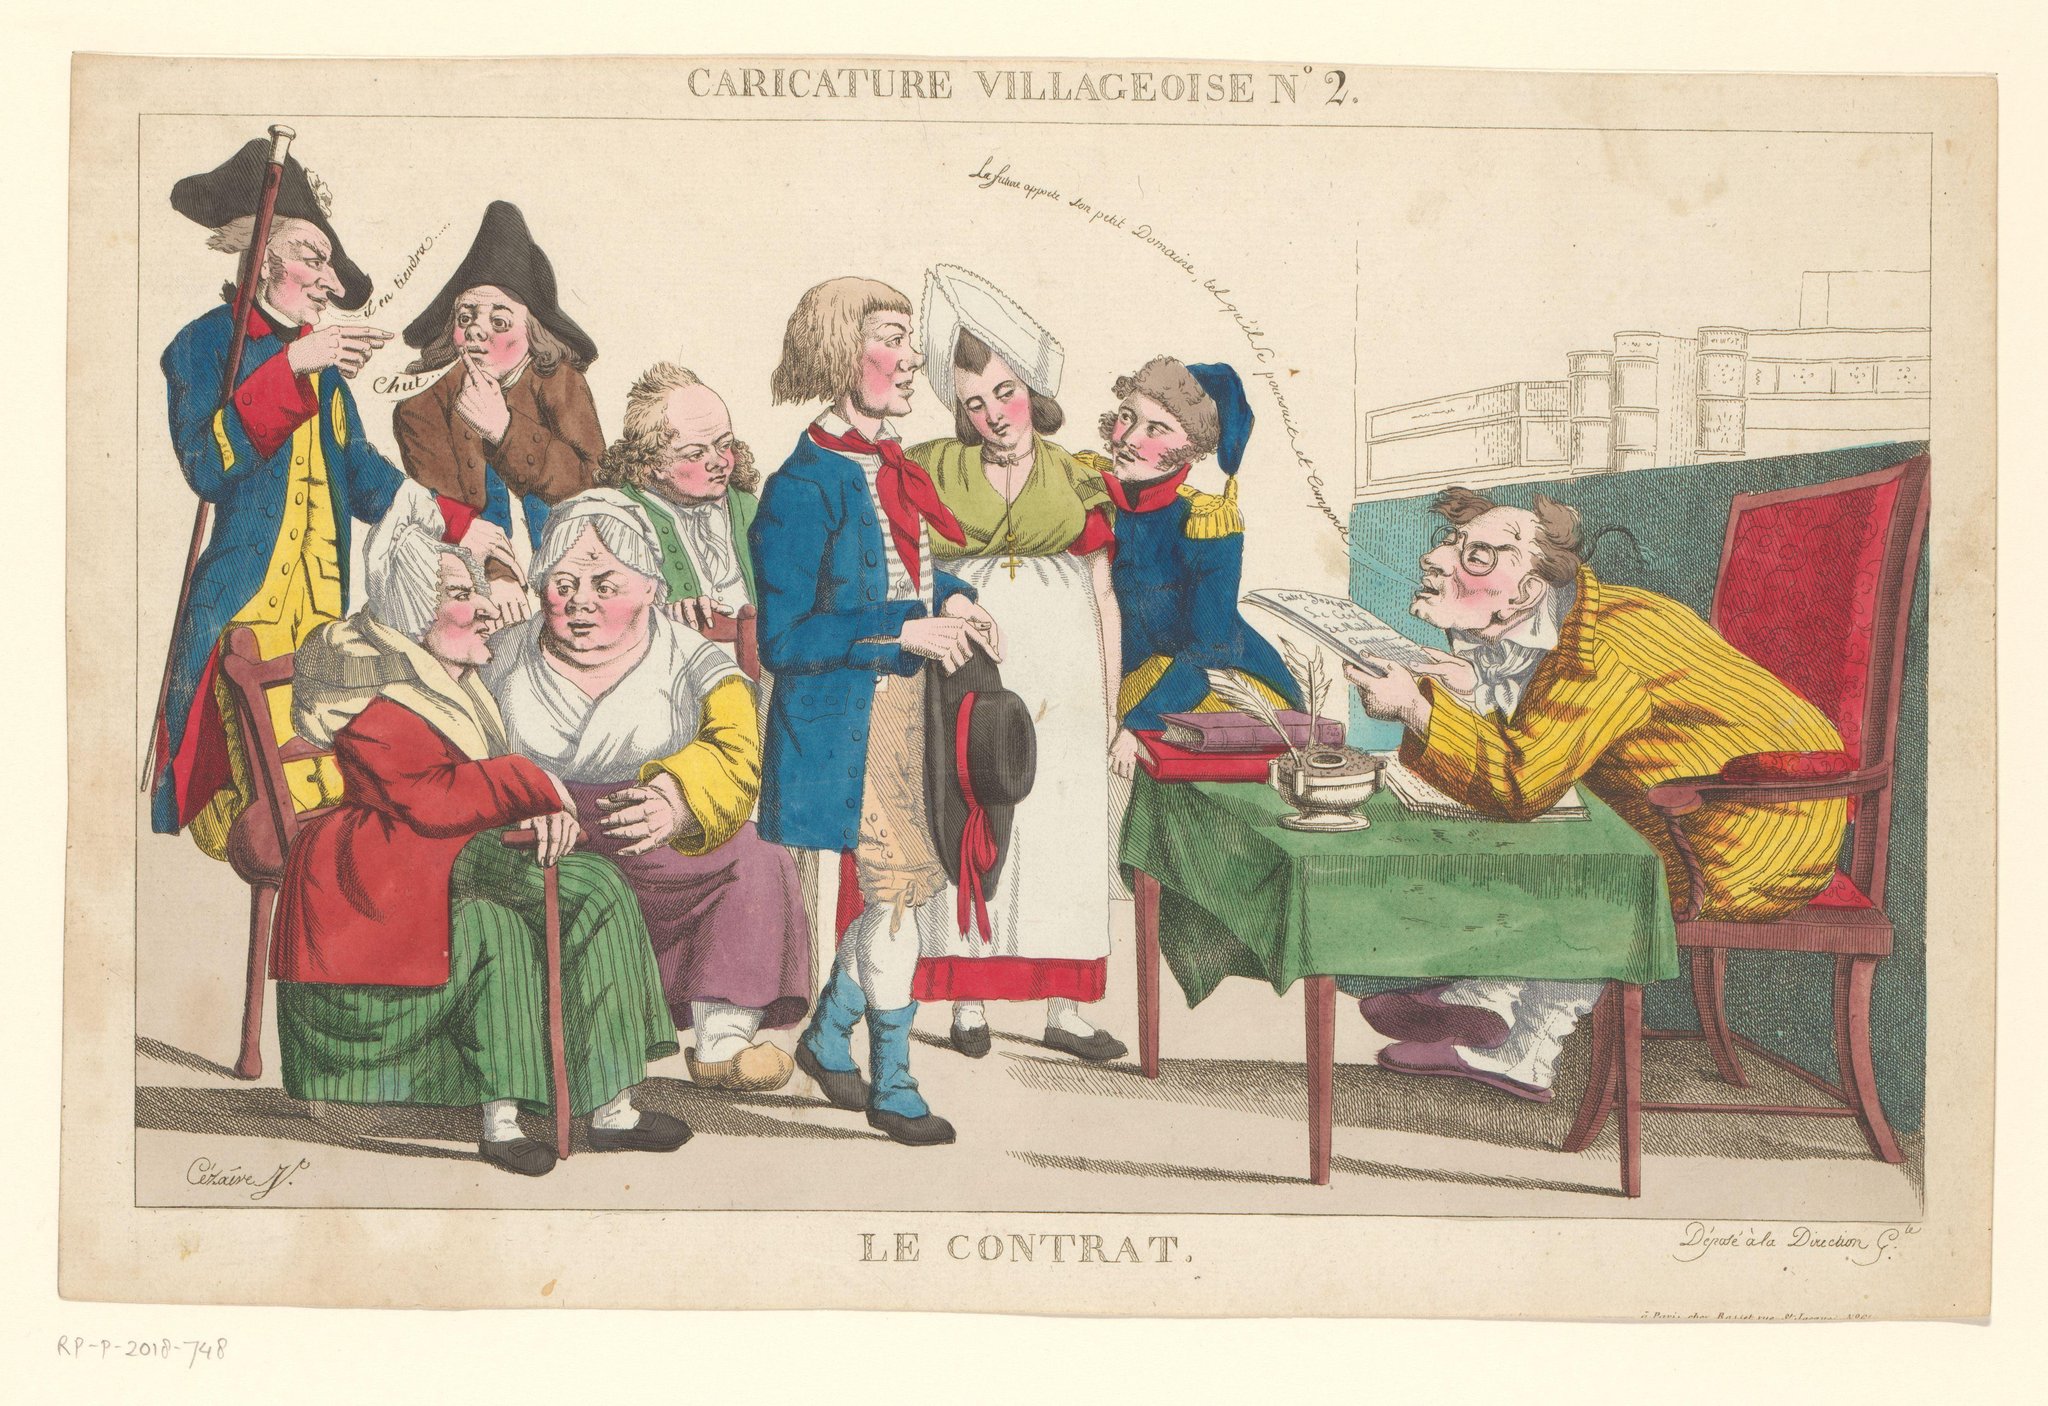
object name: cartoon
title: Caricature villageoise No. 2 / Le contrat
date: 1750-1820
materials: paper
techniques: etching, hand coloring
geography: france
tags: fool, simpleton, numskull, notary, civil law, villagers; villeins (dutch: 'dorpers')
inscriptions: collector's mark: Lugt 2228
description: Spotprent met een groep dorpelingen verzameld voor een notaris die aan een staande jongeman een tekst voorleest.